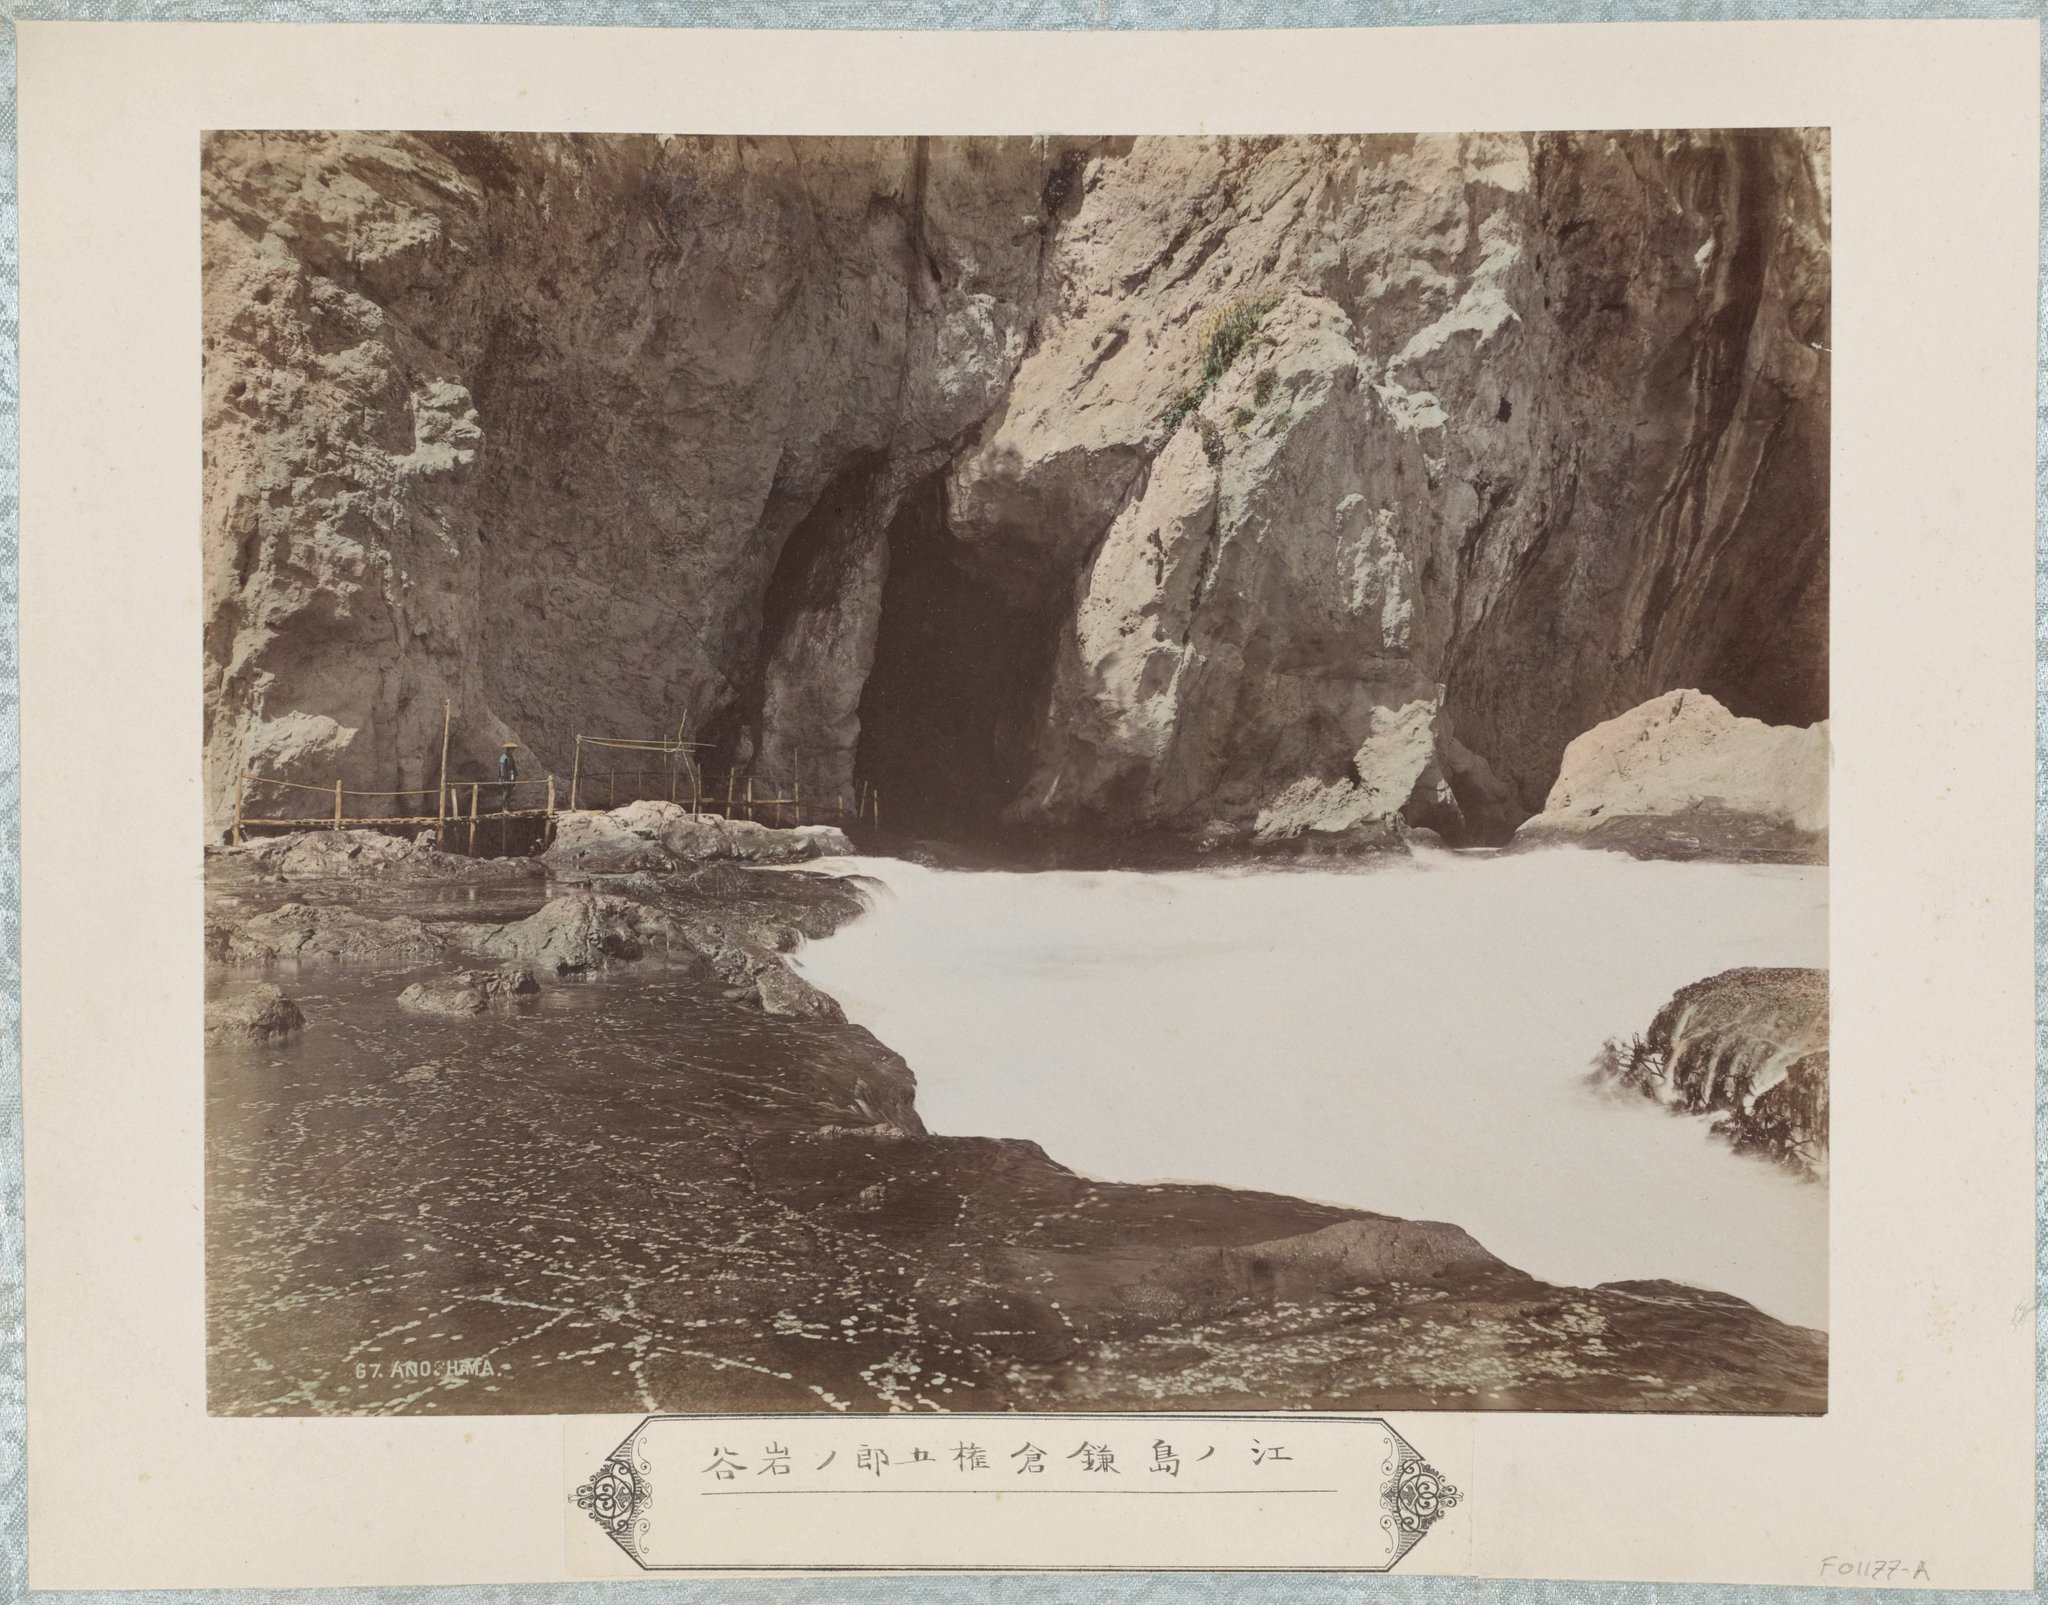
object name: photograph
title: Ingang van de Iwaya-grotten op het eiland Enoshima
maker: Anonymous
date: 1870-1900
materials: cardboard, paper, photographic support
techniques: albumen print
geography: enoshima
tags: cave, grotto, travelling; tourism, rock-formations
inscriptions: inscription: ‘Anoshima.’, negative number: ‘67’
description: Onderdeel van Leporelloalbum met 30 foto's van bezienswaardigheden in Japan.